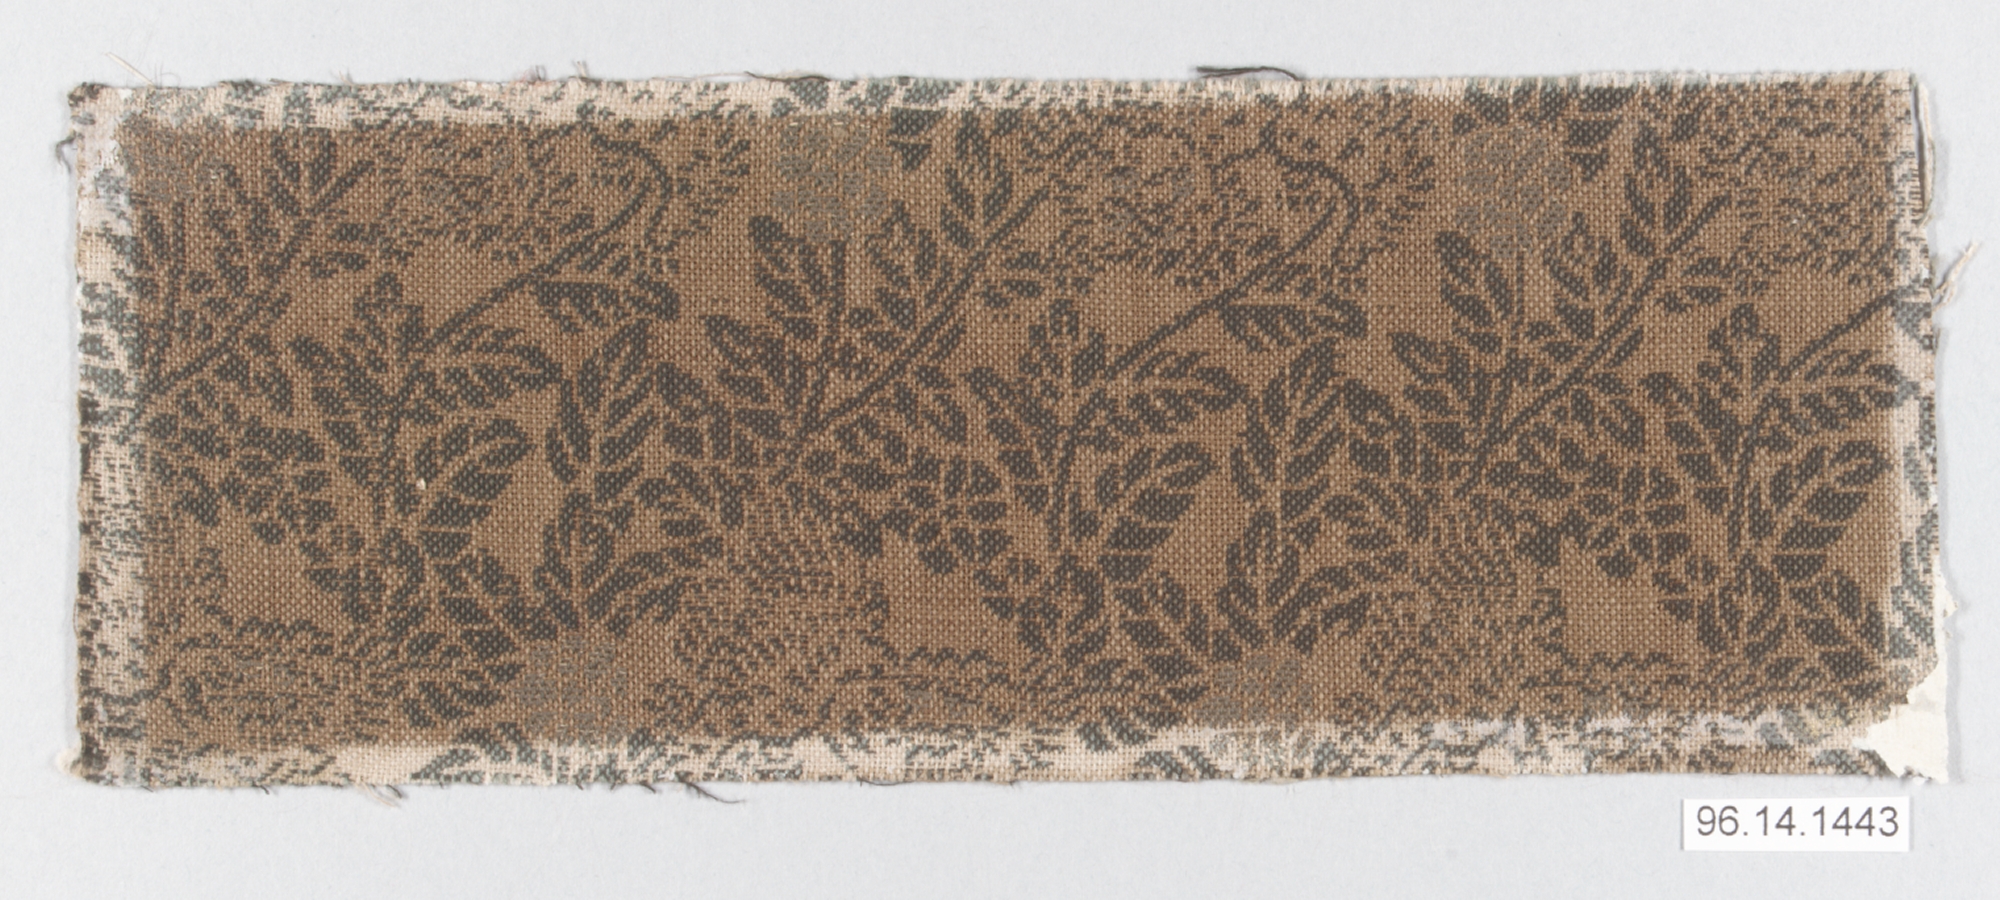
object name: piece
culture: japanese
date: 1801-1900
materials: fiber